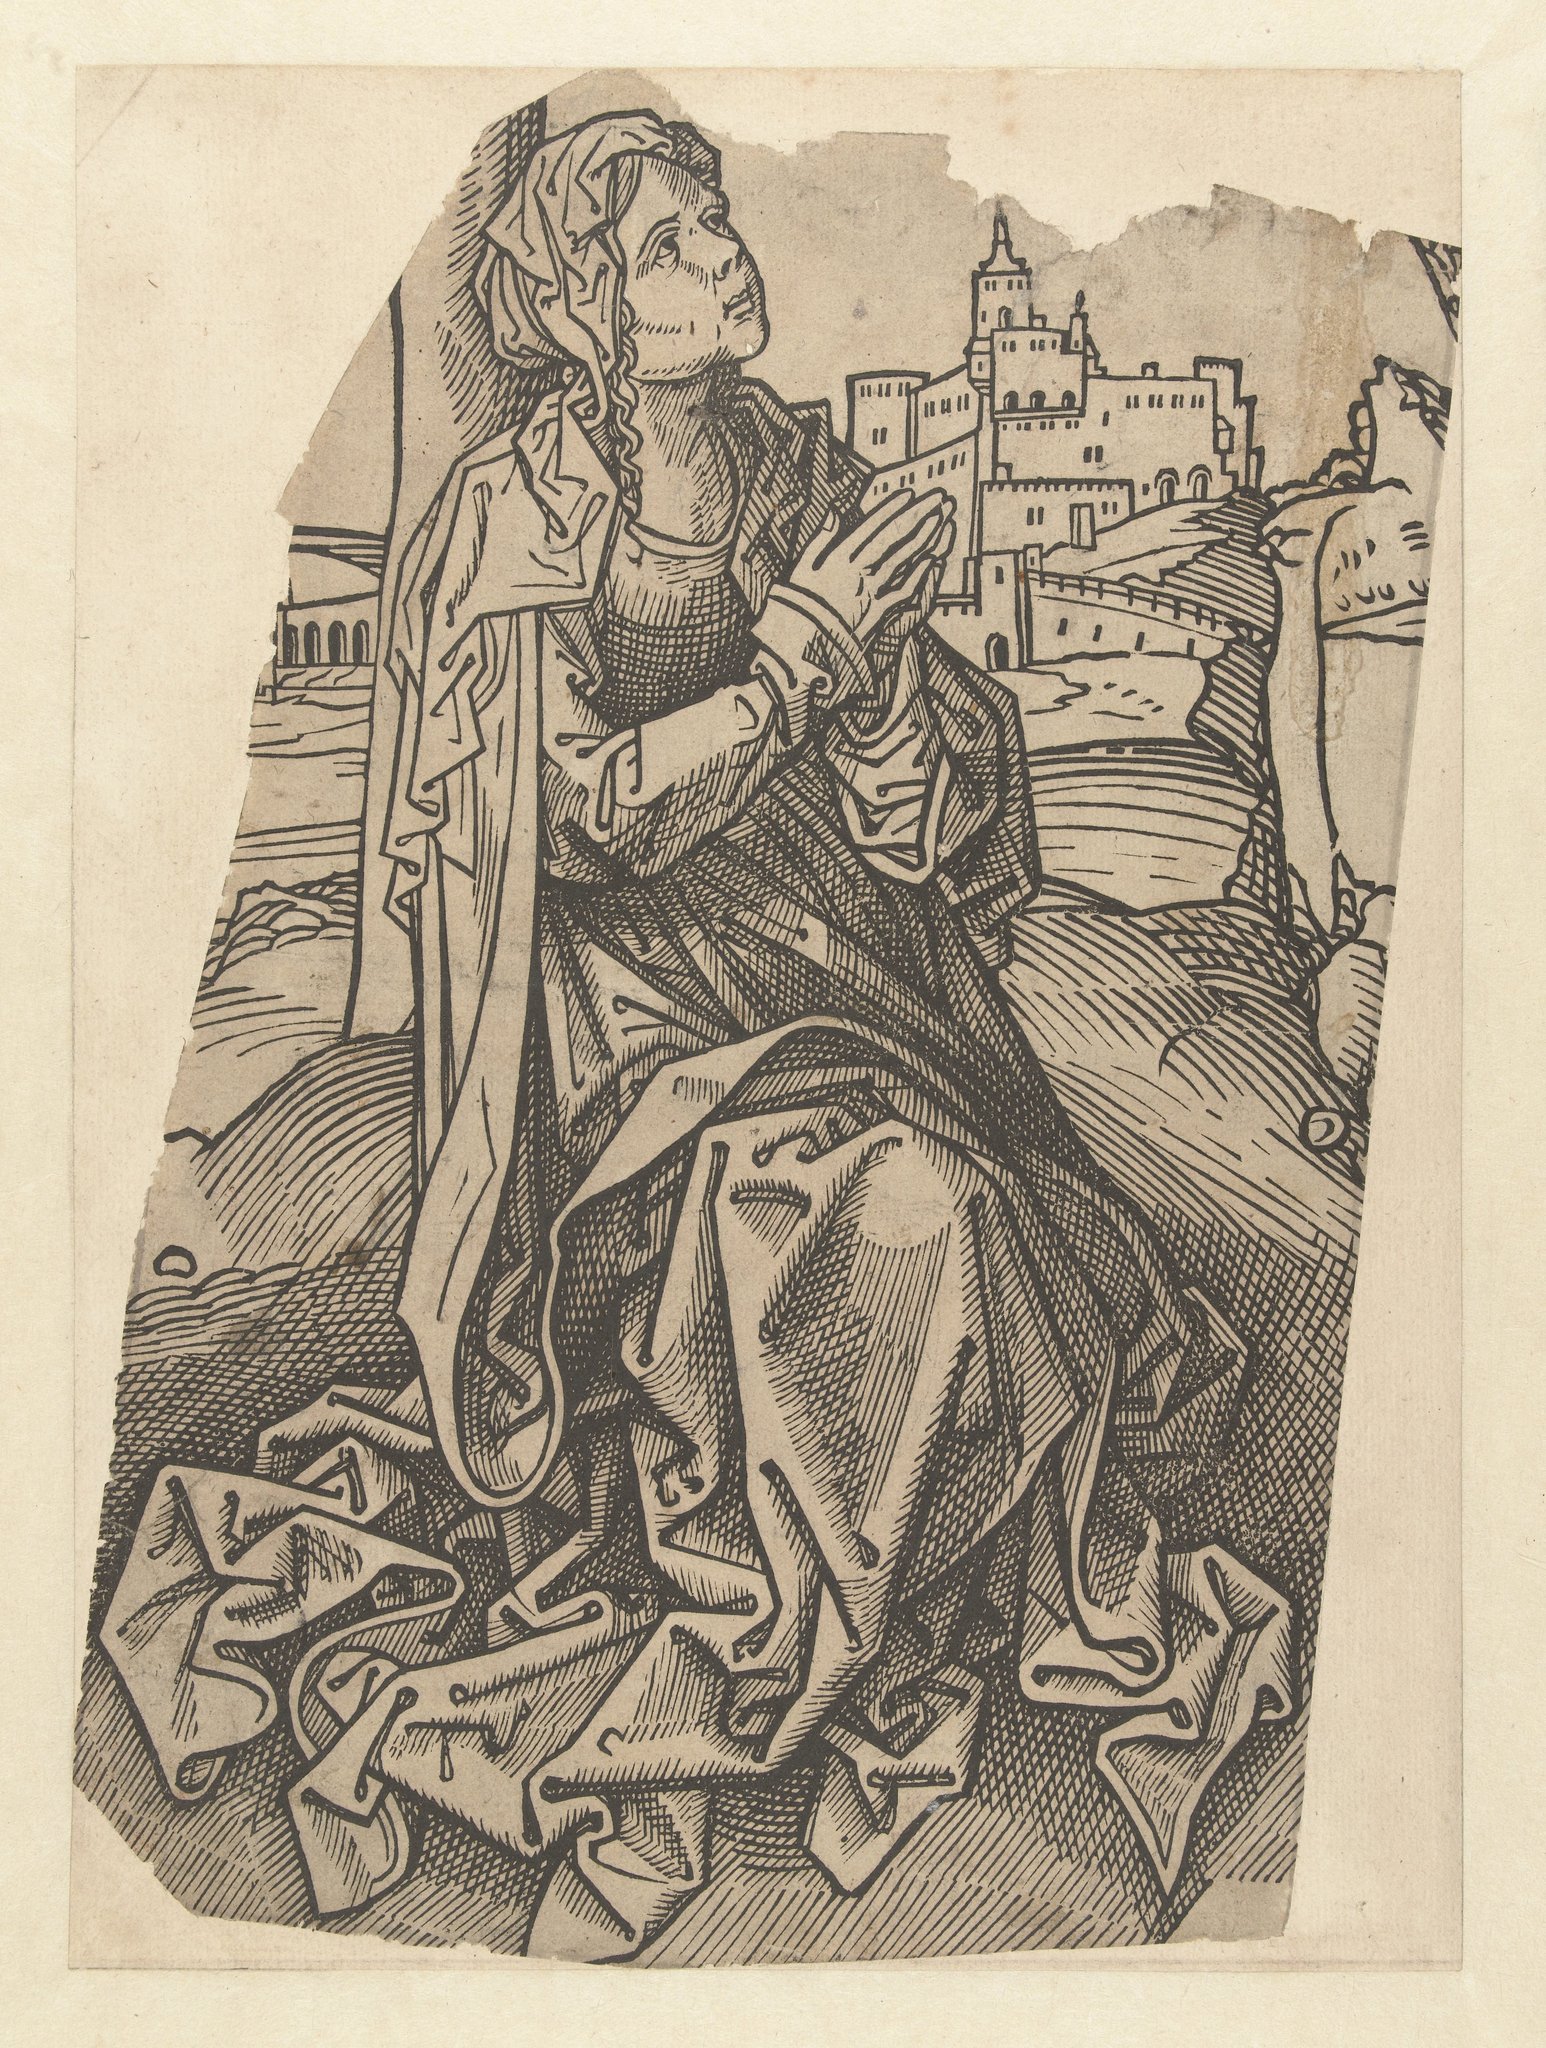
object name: print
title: Maria Magdalena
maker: Anonymous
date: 1490-1510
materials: paper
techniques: woodcut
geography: low countries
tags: crucified christ with mary magdalene, who usually weeps and embraces the cross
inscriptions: collector's mark: Lugt 2228a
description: Maria Magdalena knielend aan de voet van het kruis. Fragment uit een grotere kruisigingvoorstelling.